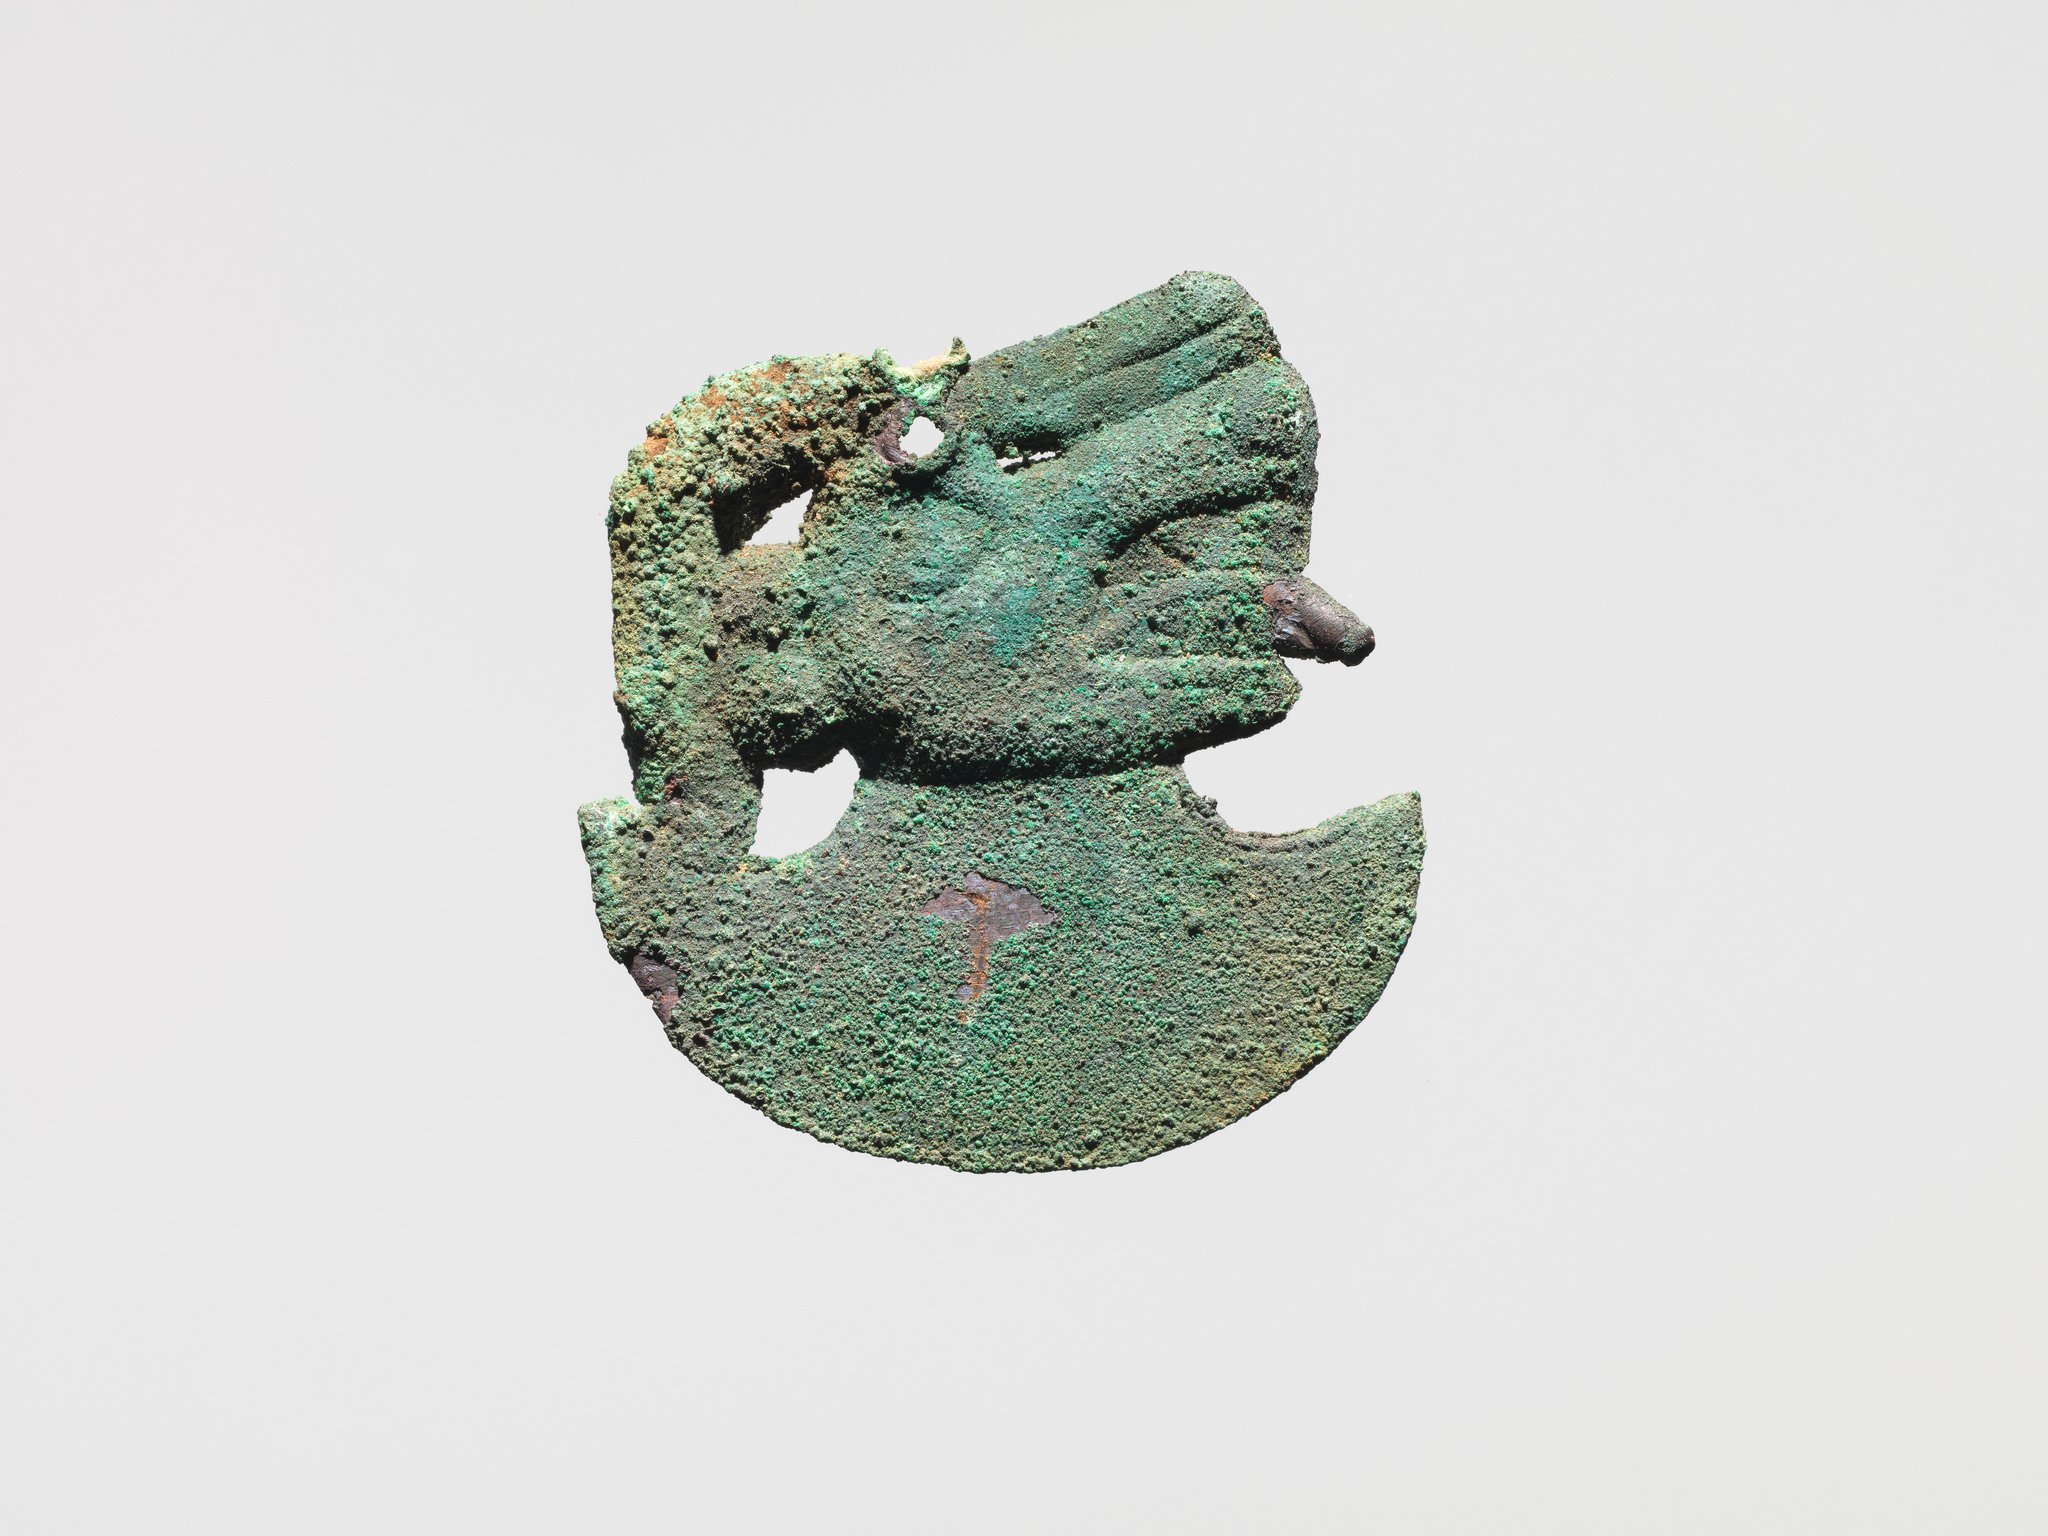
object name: ornament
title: Crescent Ornaments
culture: moche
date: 501-700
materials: copper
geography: peru